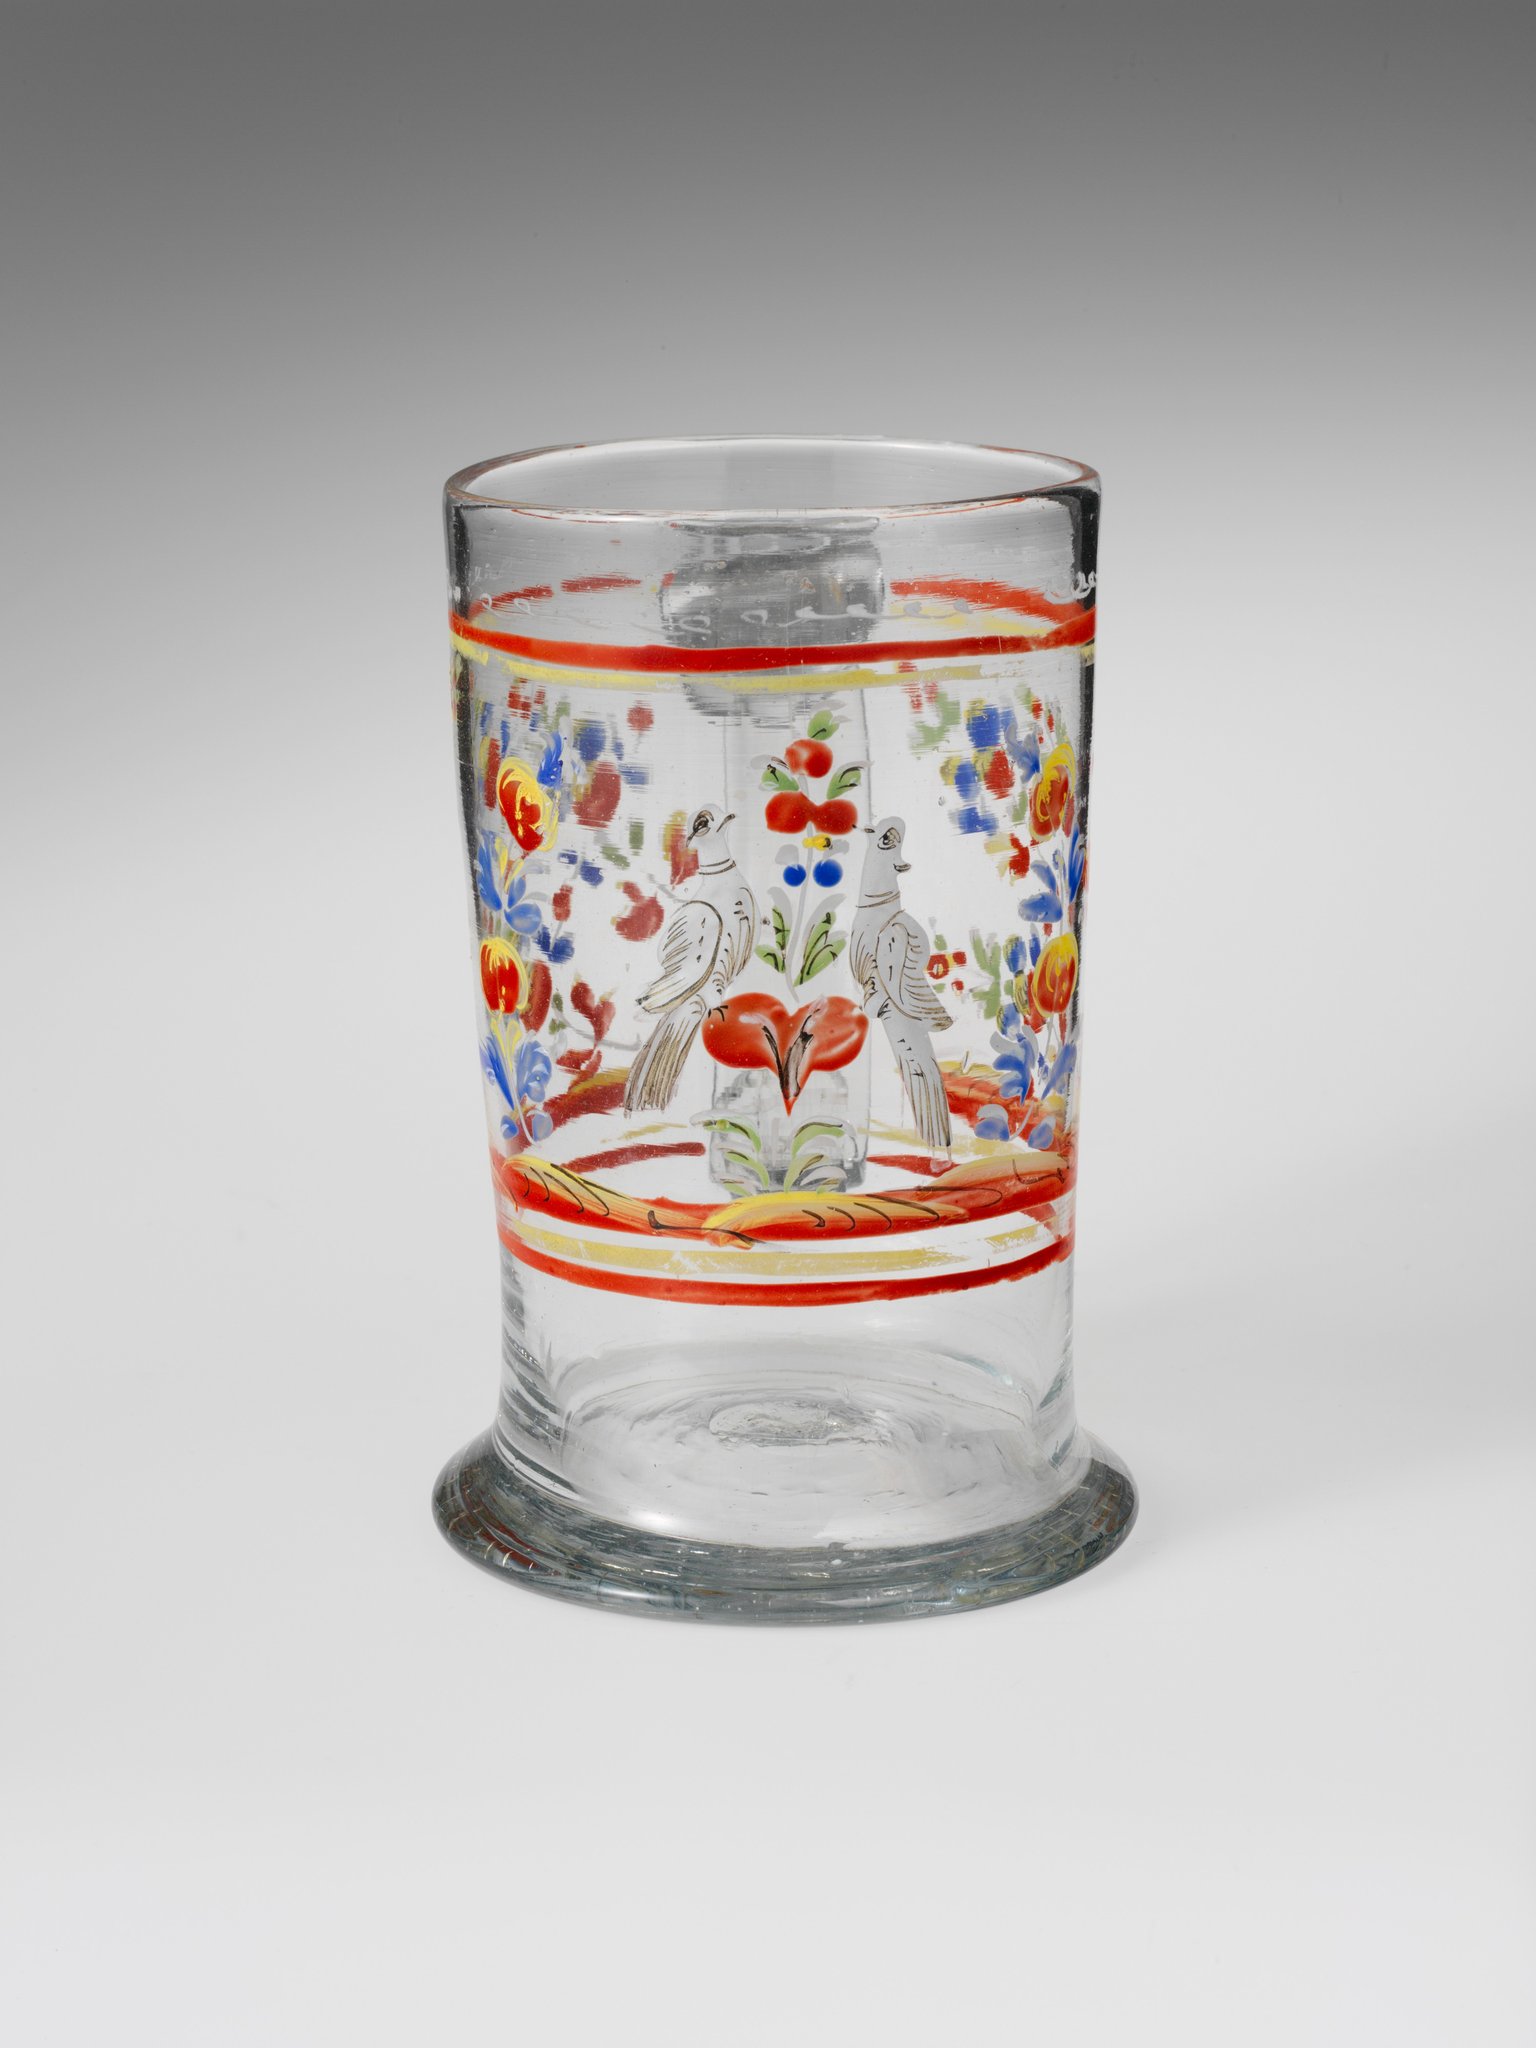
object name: mug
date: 1700-1800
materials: enamel, glass, lead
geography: czech republic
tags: birds